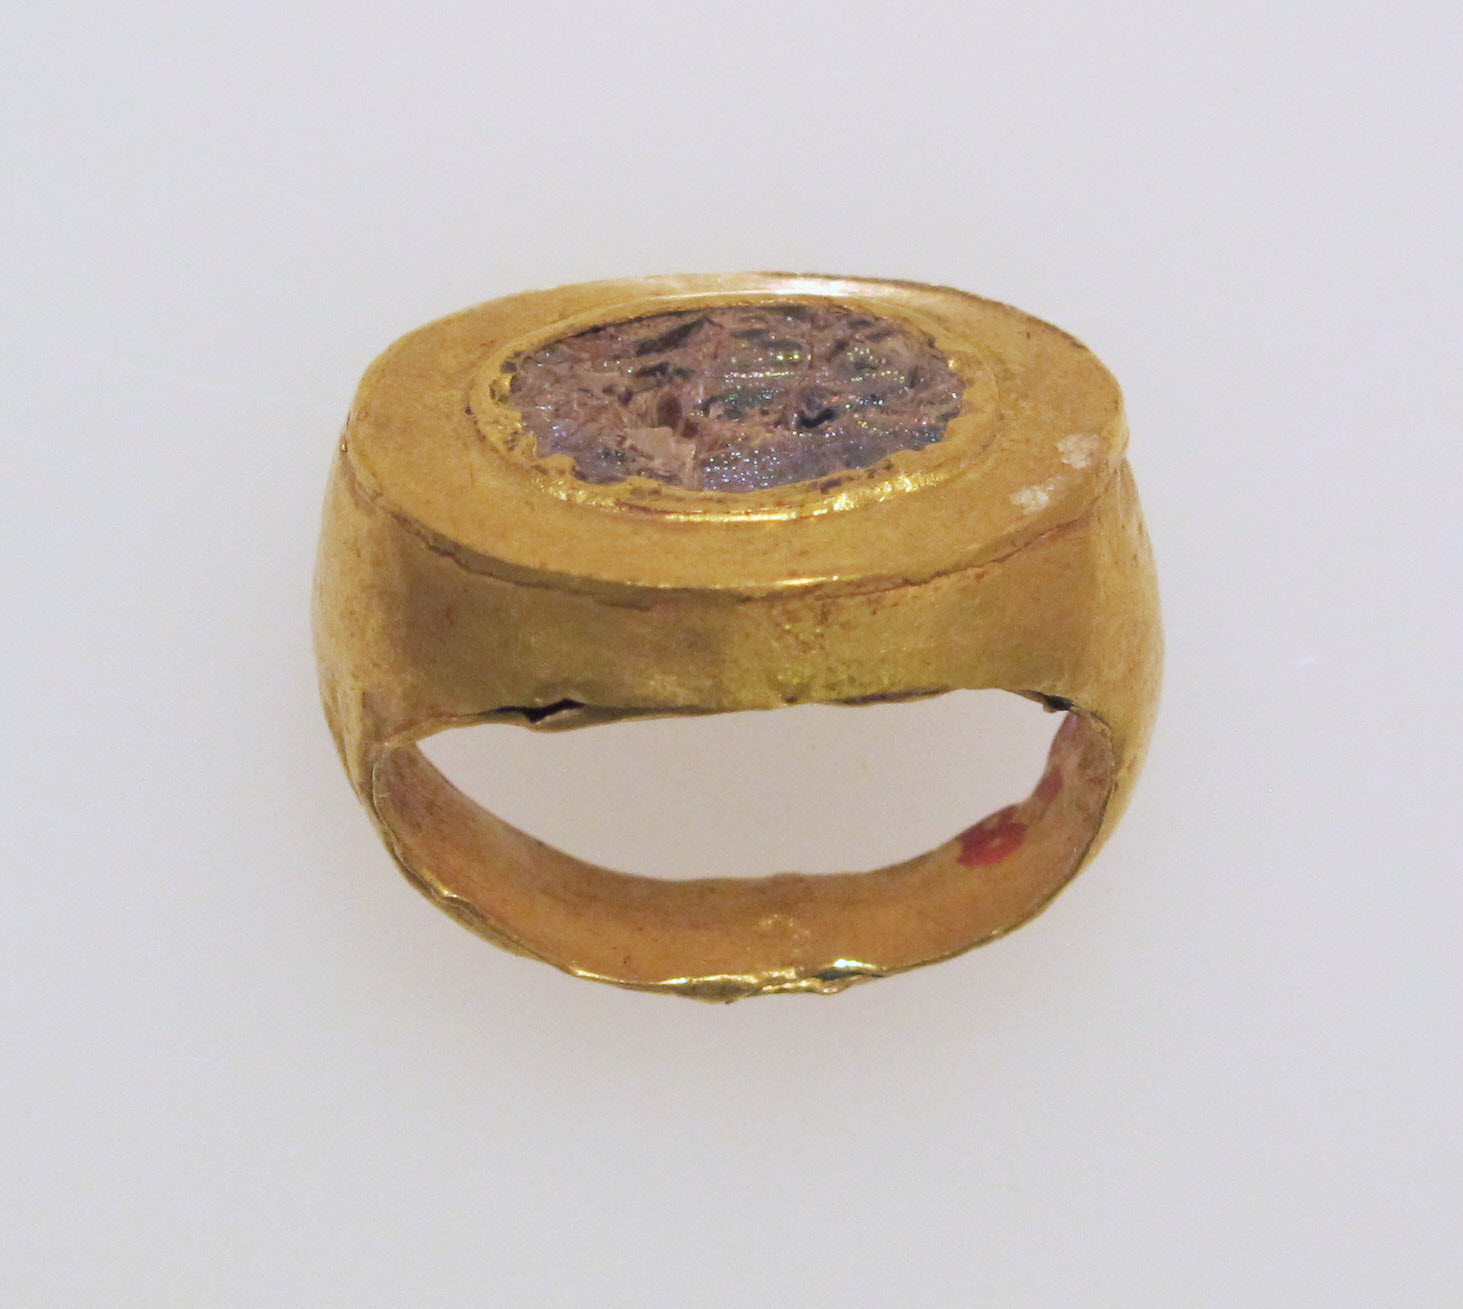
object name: ring with glass paste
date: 7000 BCE-330 CE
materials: glass, gold, paste